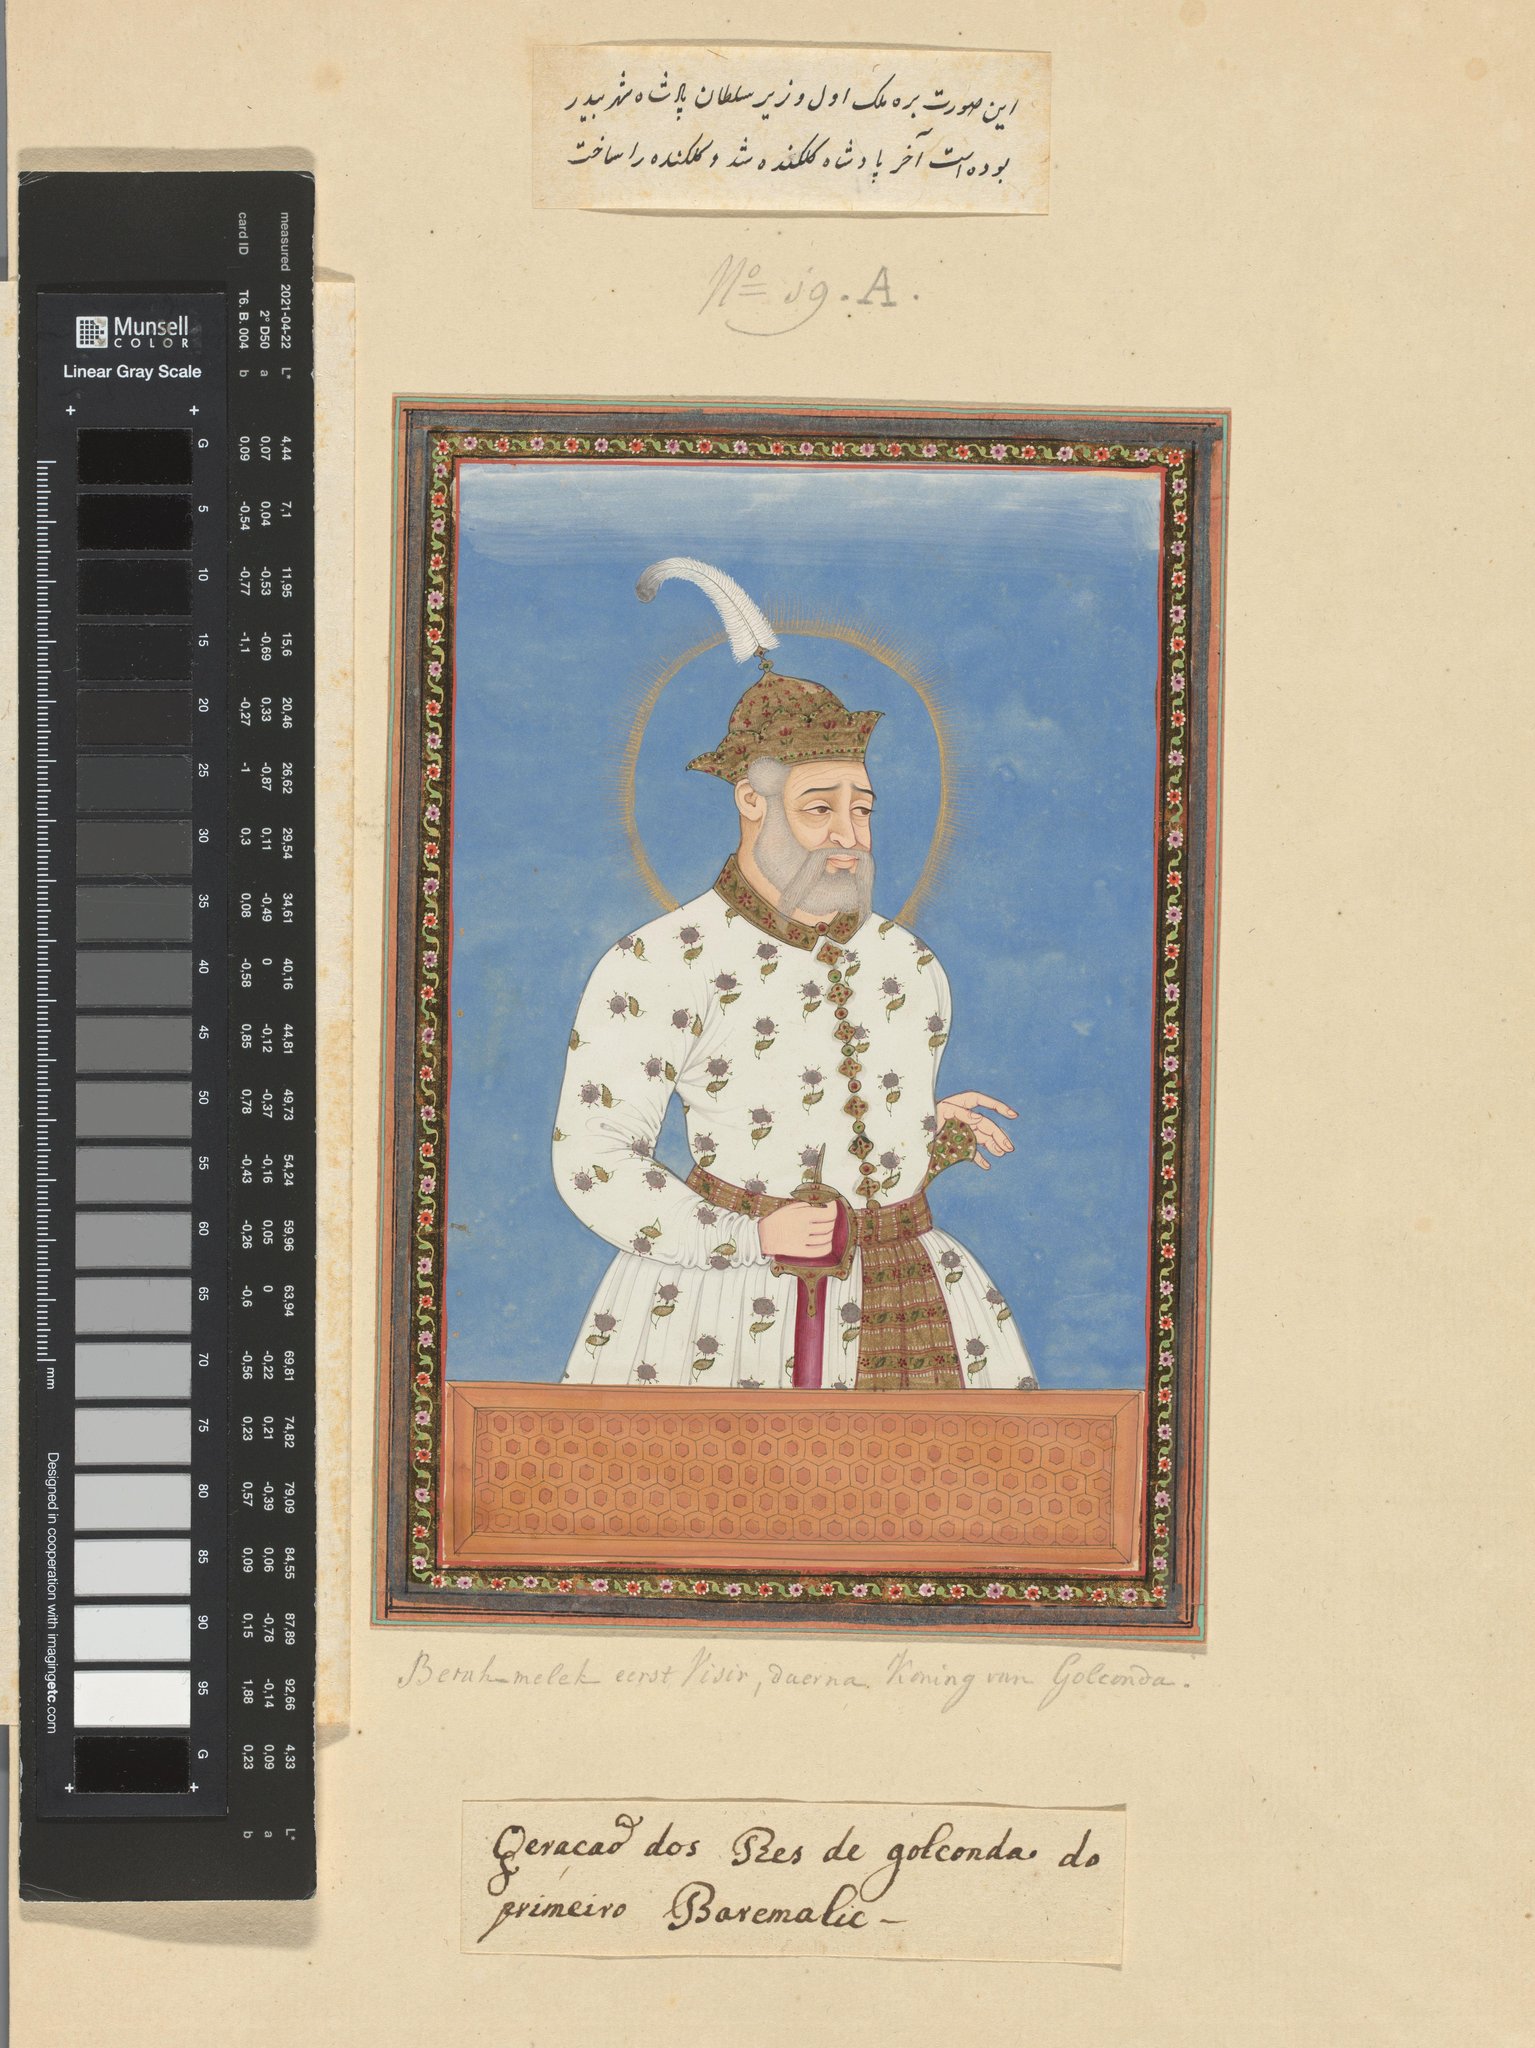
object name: indian miniature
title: Portret van Bara Malik; hij is eerst vizier geweest van de sultan die over de stad Bidar regeerde (?); later werd hij heerser van Golconda en heeft hij Golconda gesticht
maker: Anonymous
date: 1686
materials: paint, gold leaf, gouache, paper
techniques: brush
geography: golkonda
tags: amsterdam, mayor, nicolaes cornelisz. witsen, historical person (...) - historical person (...) portrayed alone, ruler, sovereign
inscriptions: collector's mark: Lugt 240, annotation: ‘Berah-melek eerst Visir, daarna Koning van Golconda’, collector's mark: Lugt 1838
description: Bara Malik is tot aan zijn heupen afgebeeld, half naar rechts gewend, met zijn rechter hand op zijn zwaard, en zijn linker hand op een in zijn gordel gestoken dolk. Blad 19A in het `Witsen-Album', met 49 Indiase miniaturen van vorsten. Boven het portret een stukje papier met de naam in het Perzisch. Onder het portret een stukje papier met de naam in het Portugees.